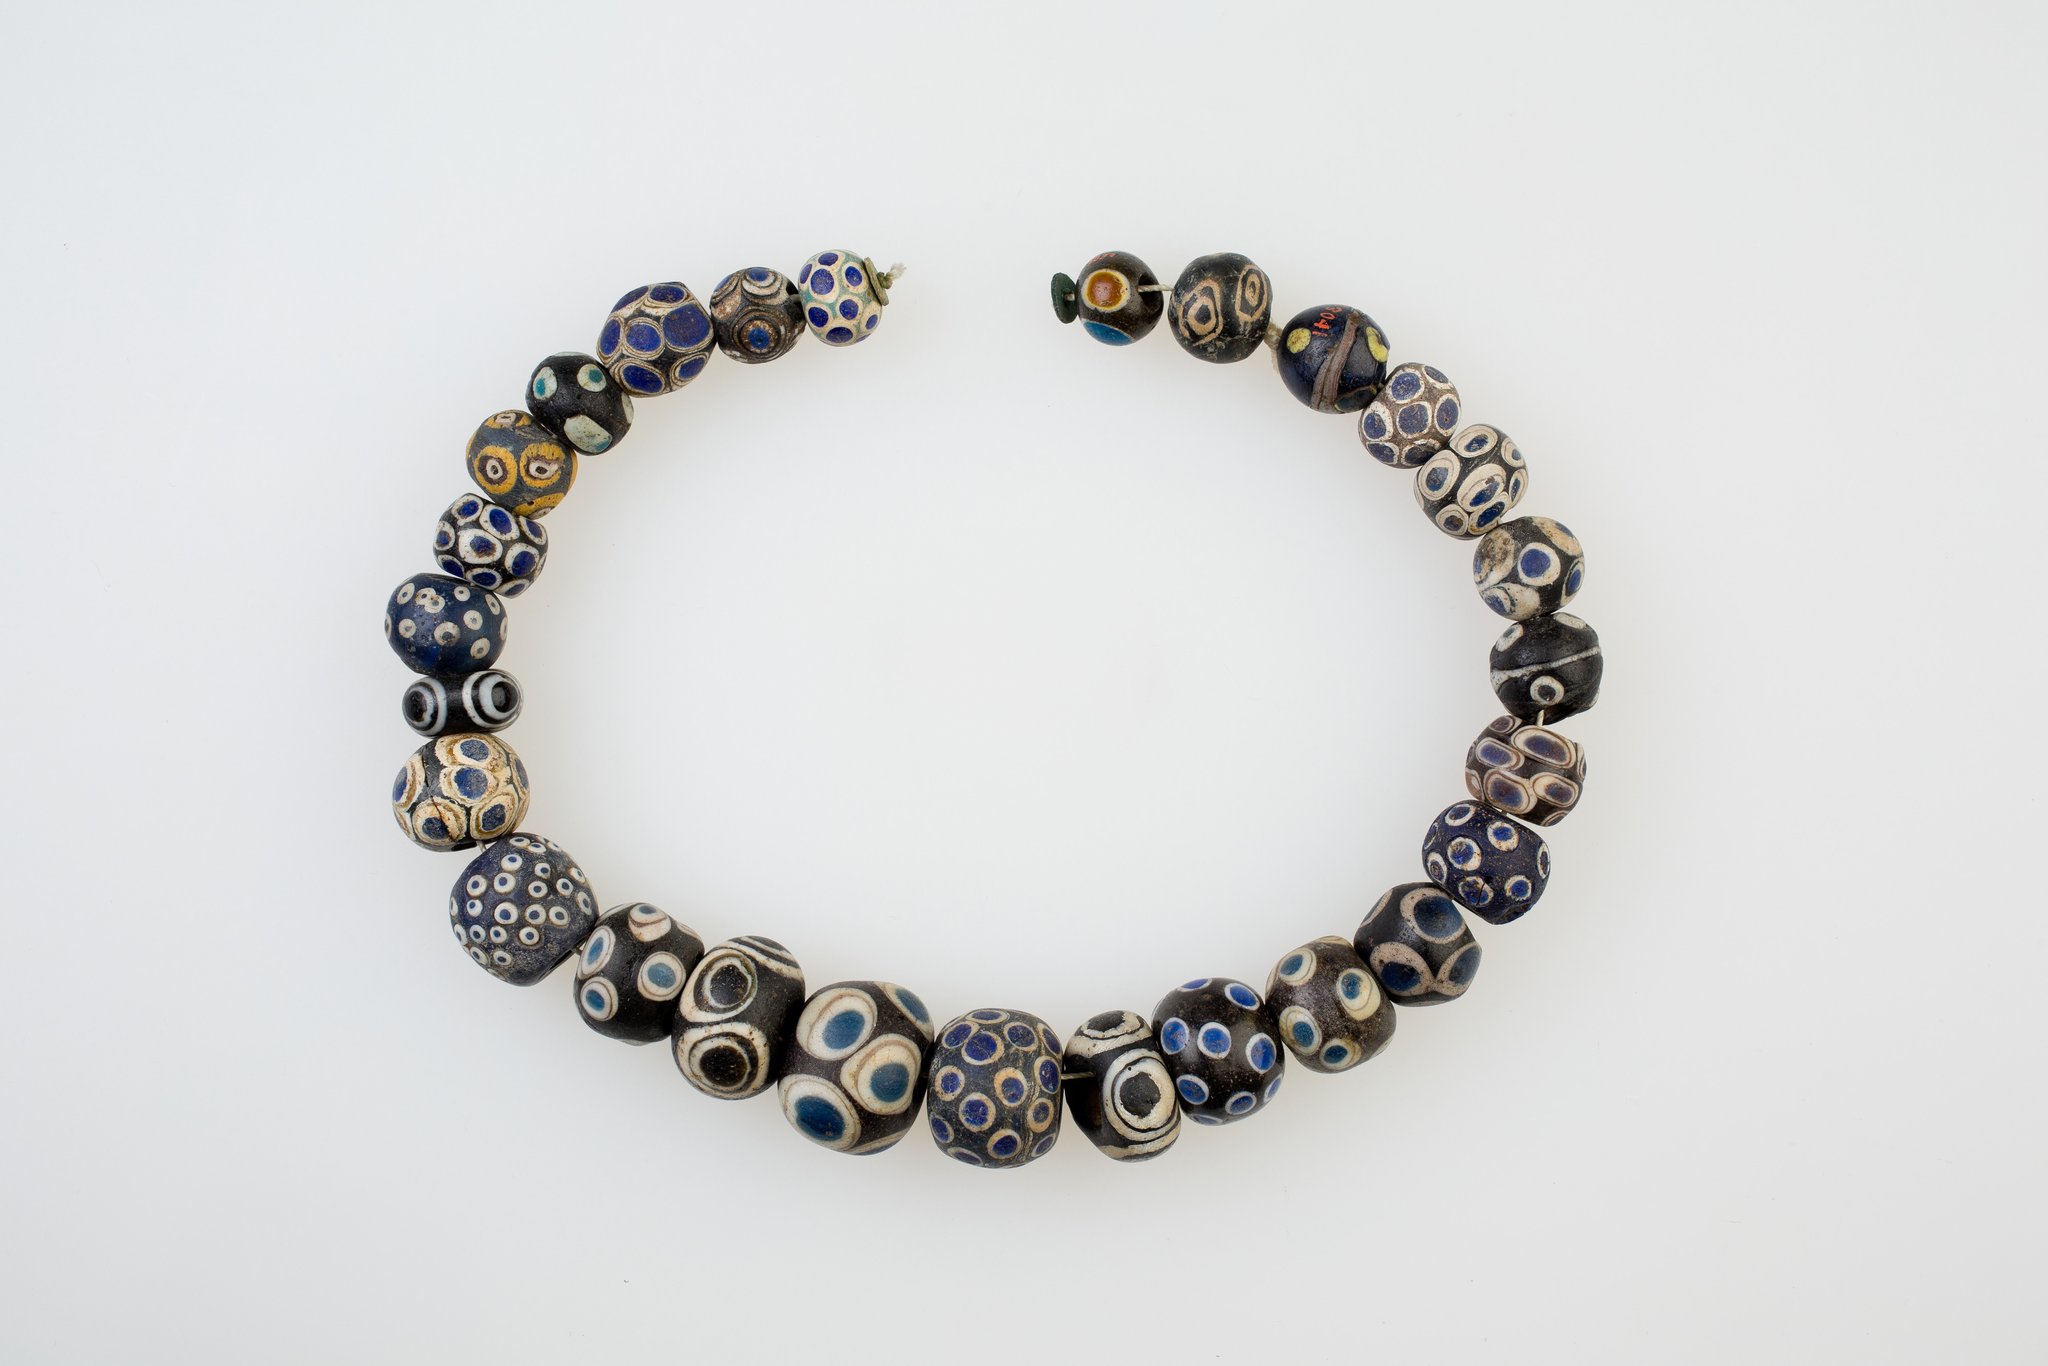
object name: necklace, bead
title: String of 27 Eye Beads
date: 600-201 BCE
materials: glass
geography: egypt